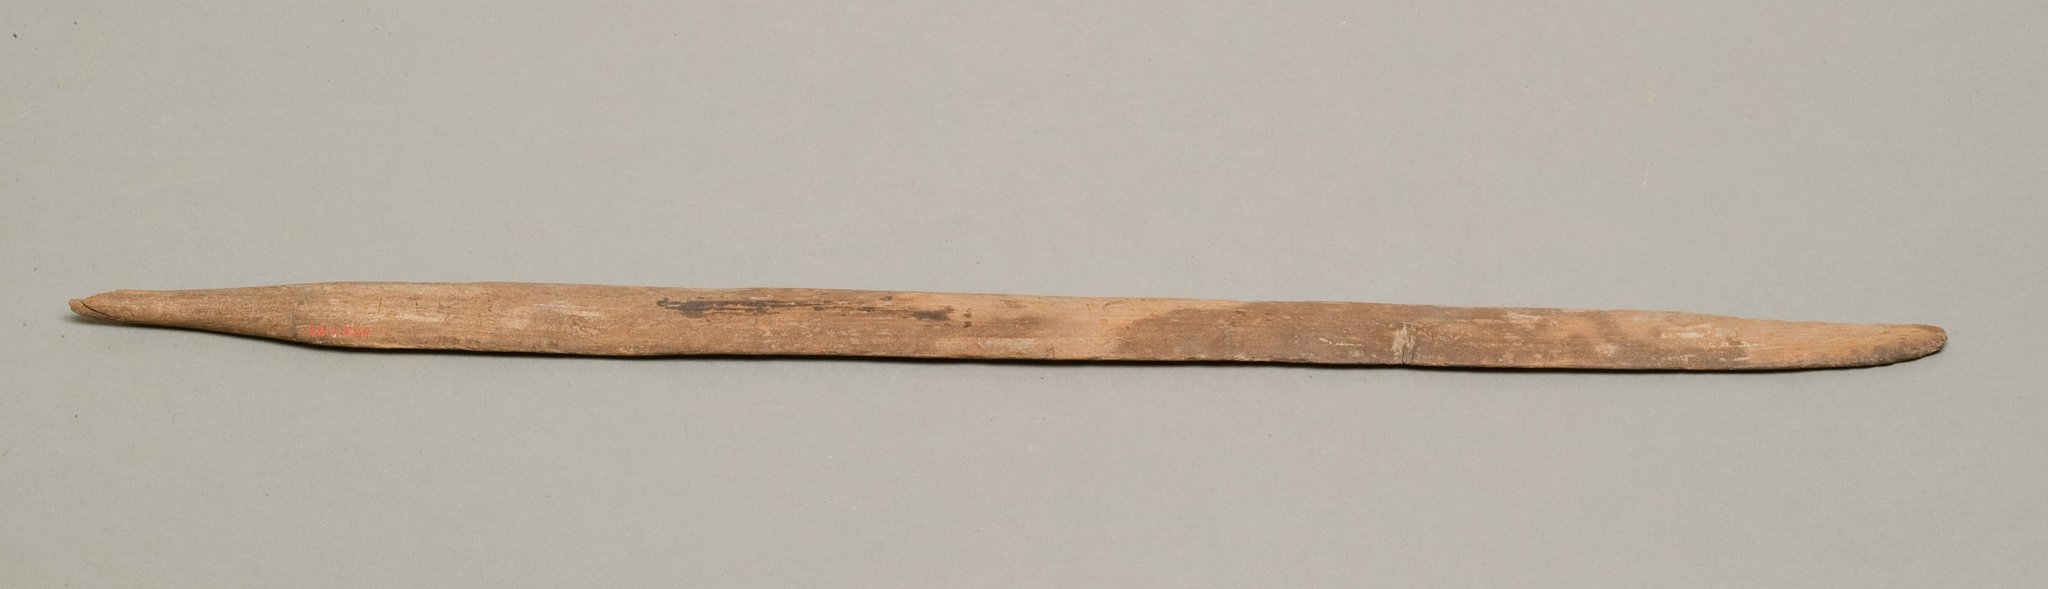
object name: weaving tool beater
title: Weaving tool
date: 1295-1070 BCE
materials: wood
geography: egypt